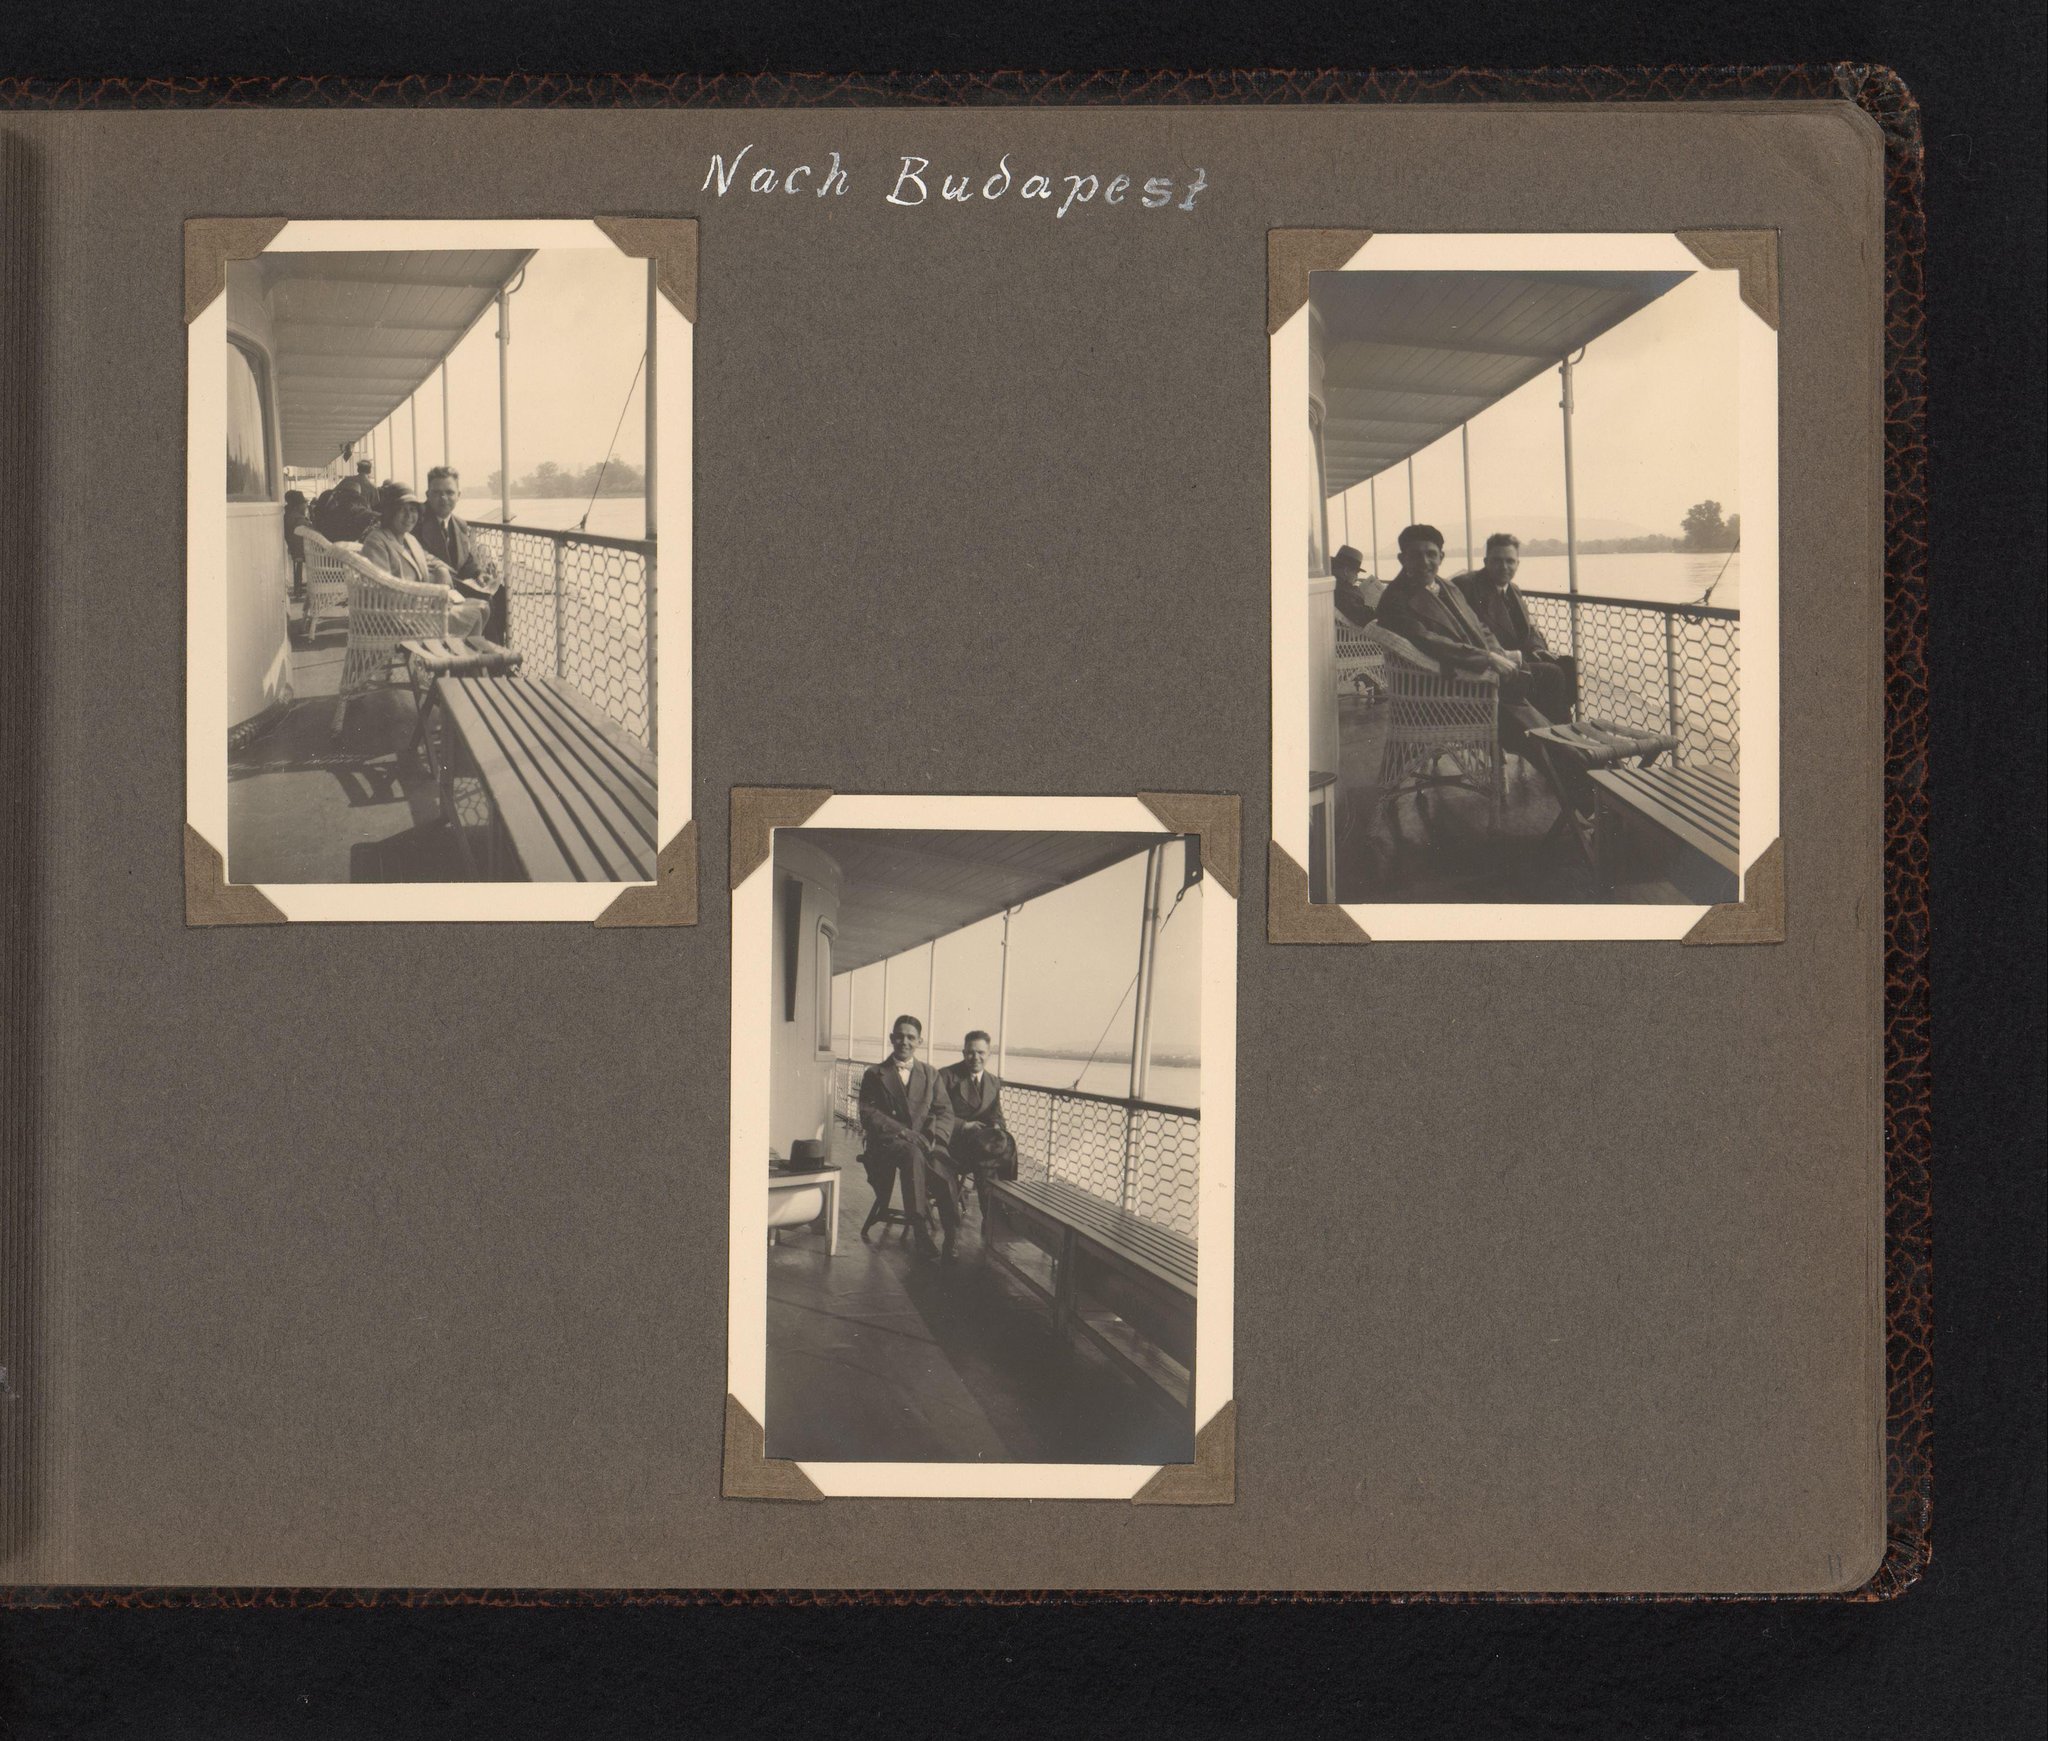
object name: album leaf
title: Boottocht over de Donau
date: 1930-1931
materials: cardboard, paper, photographic support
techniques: gelatin silver print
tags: herman besselaar, berti hoppe, historical persons - bb - woman, historical persons, steamship, motorship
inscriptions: annotation: ‘Nach Budapest’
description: Drie foto's van Berti Hoppe, Herman Besselaar en twee kennissen tijdens de boottocht over de Donau. Deze pagina maakt deel uit van een album.